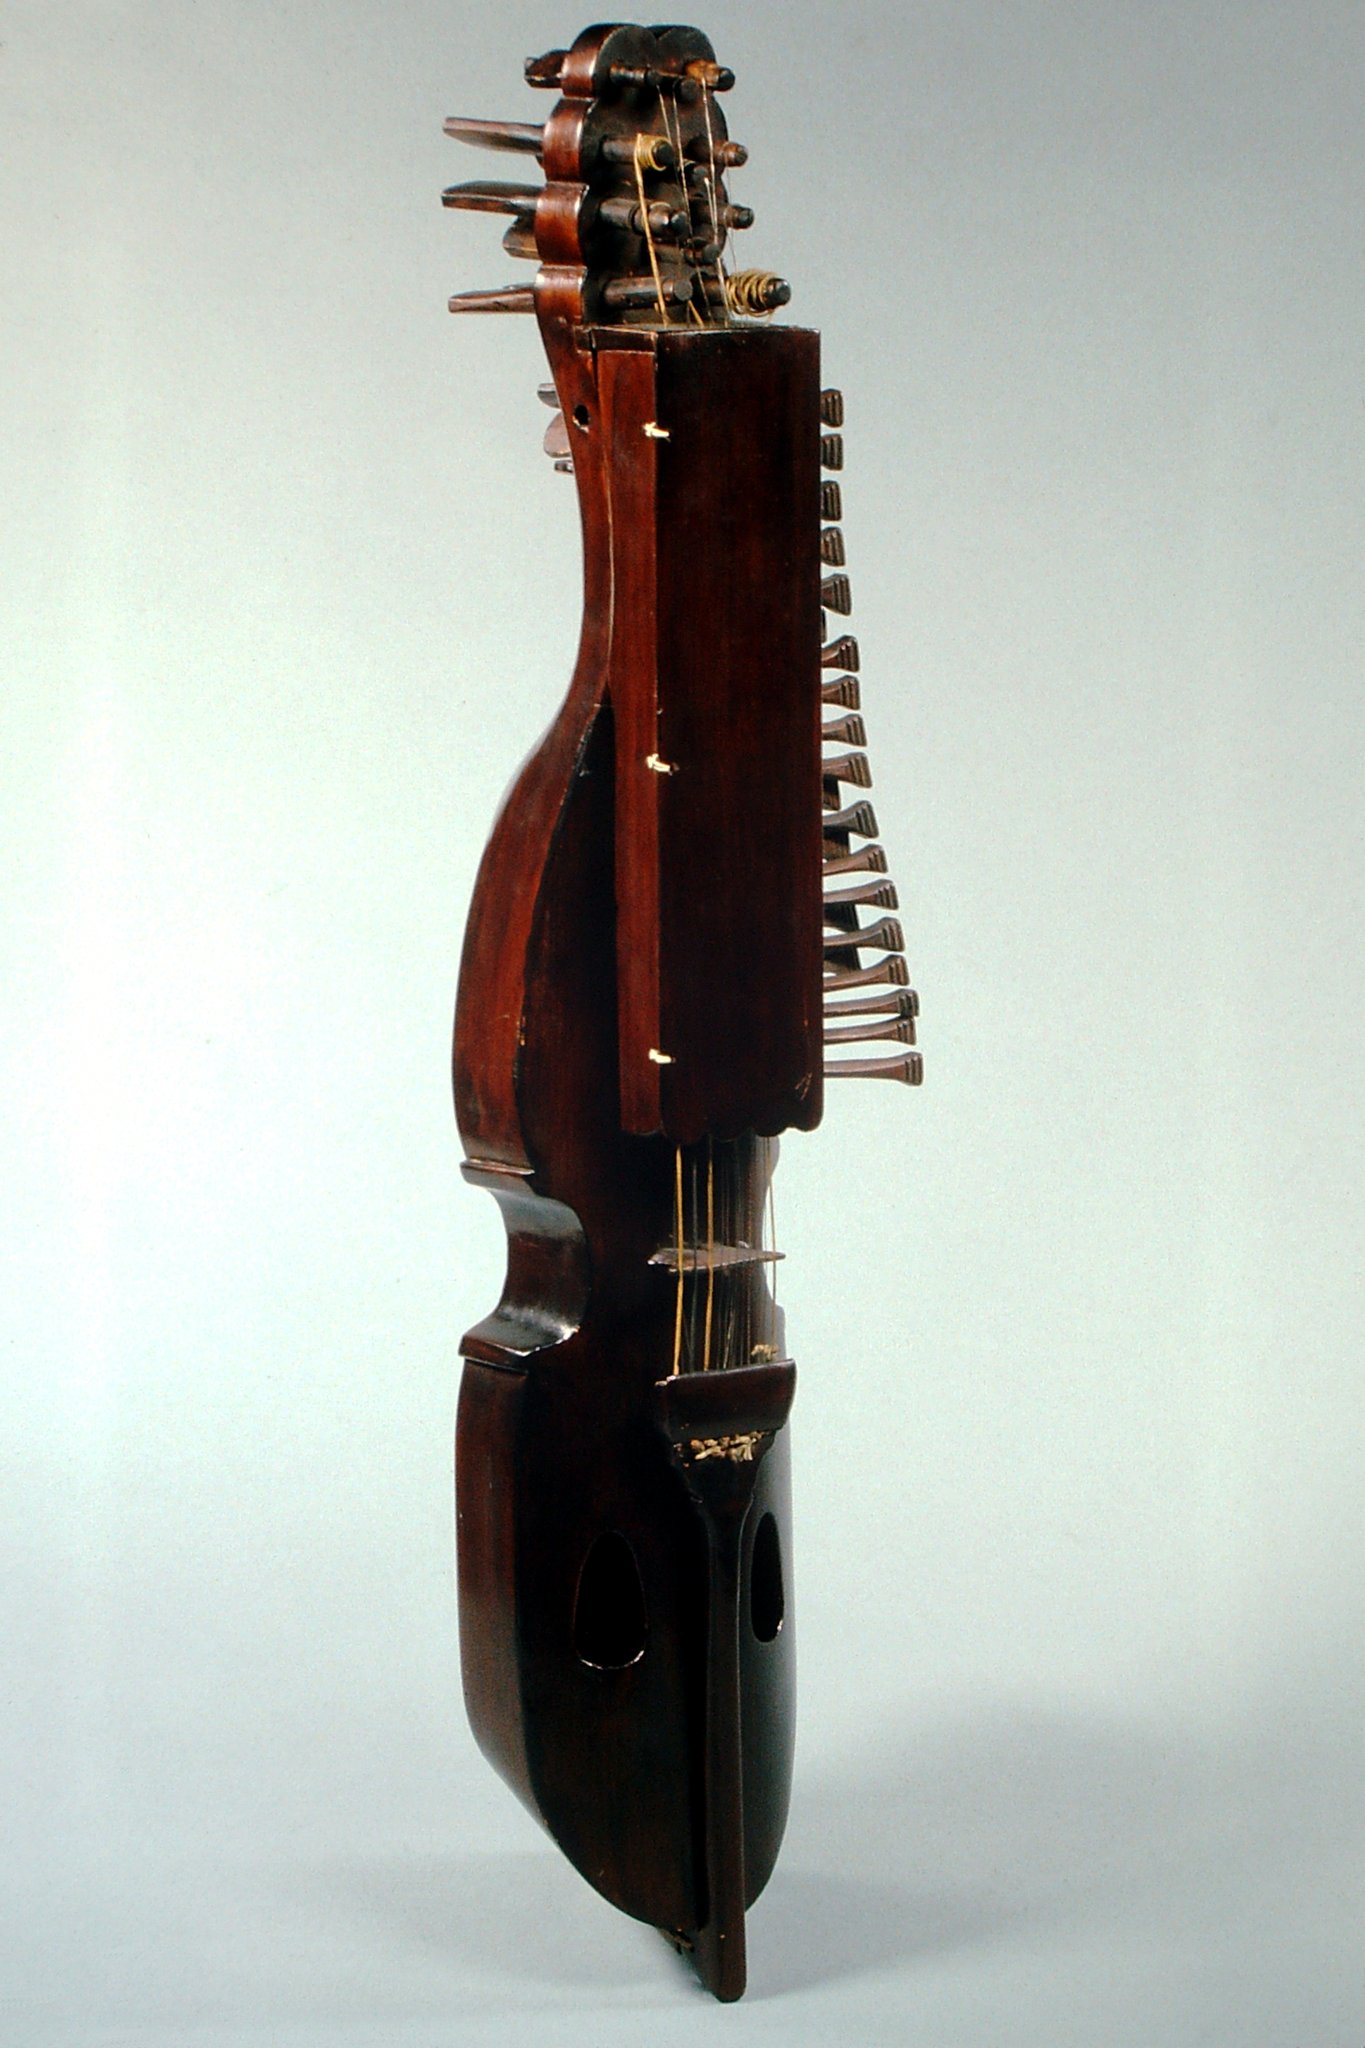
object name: nyckelharpa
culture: swedish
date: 1801-1900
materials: wood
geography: sweden